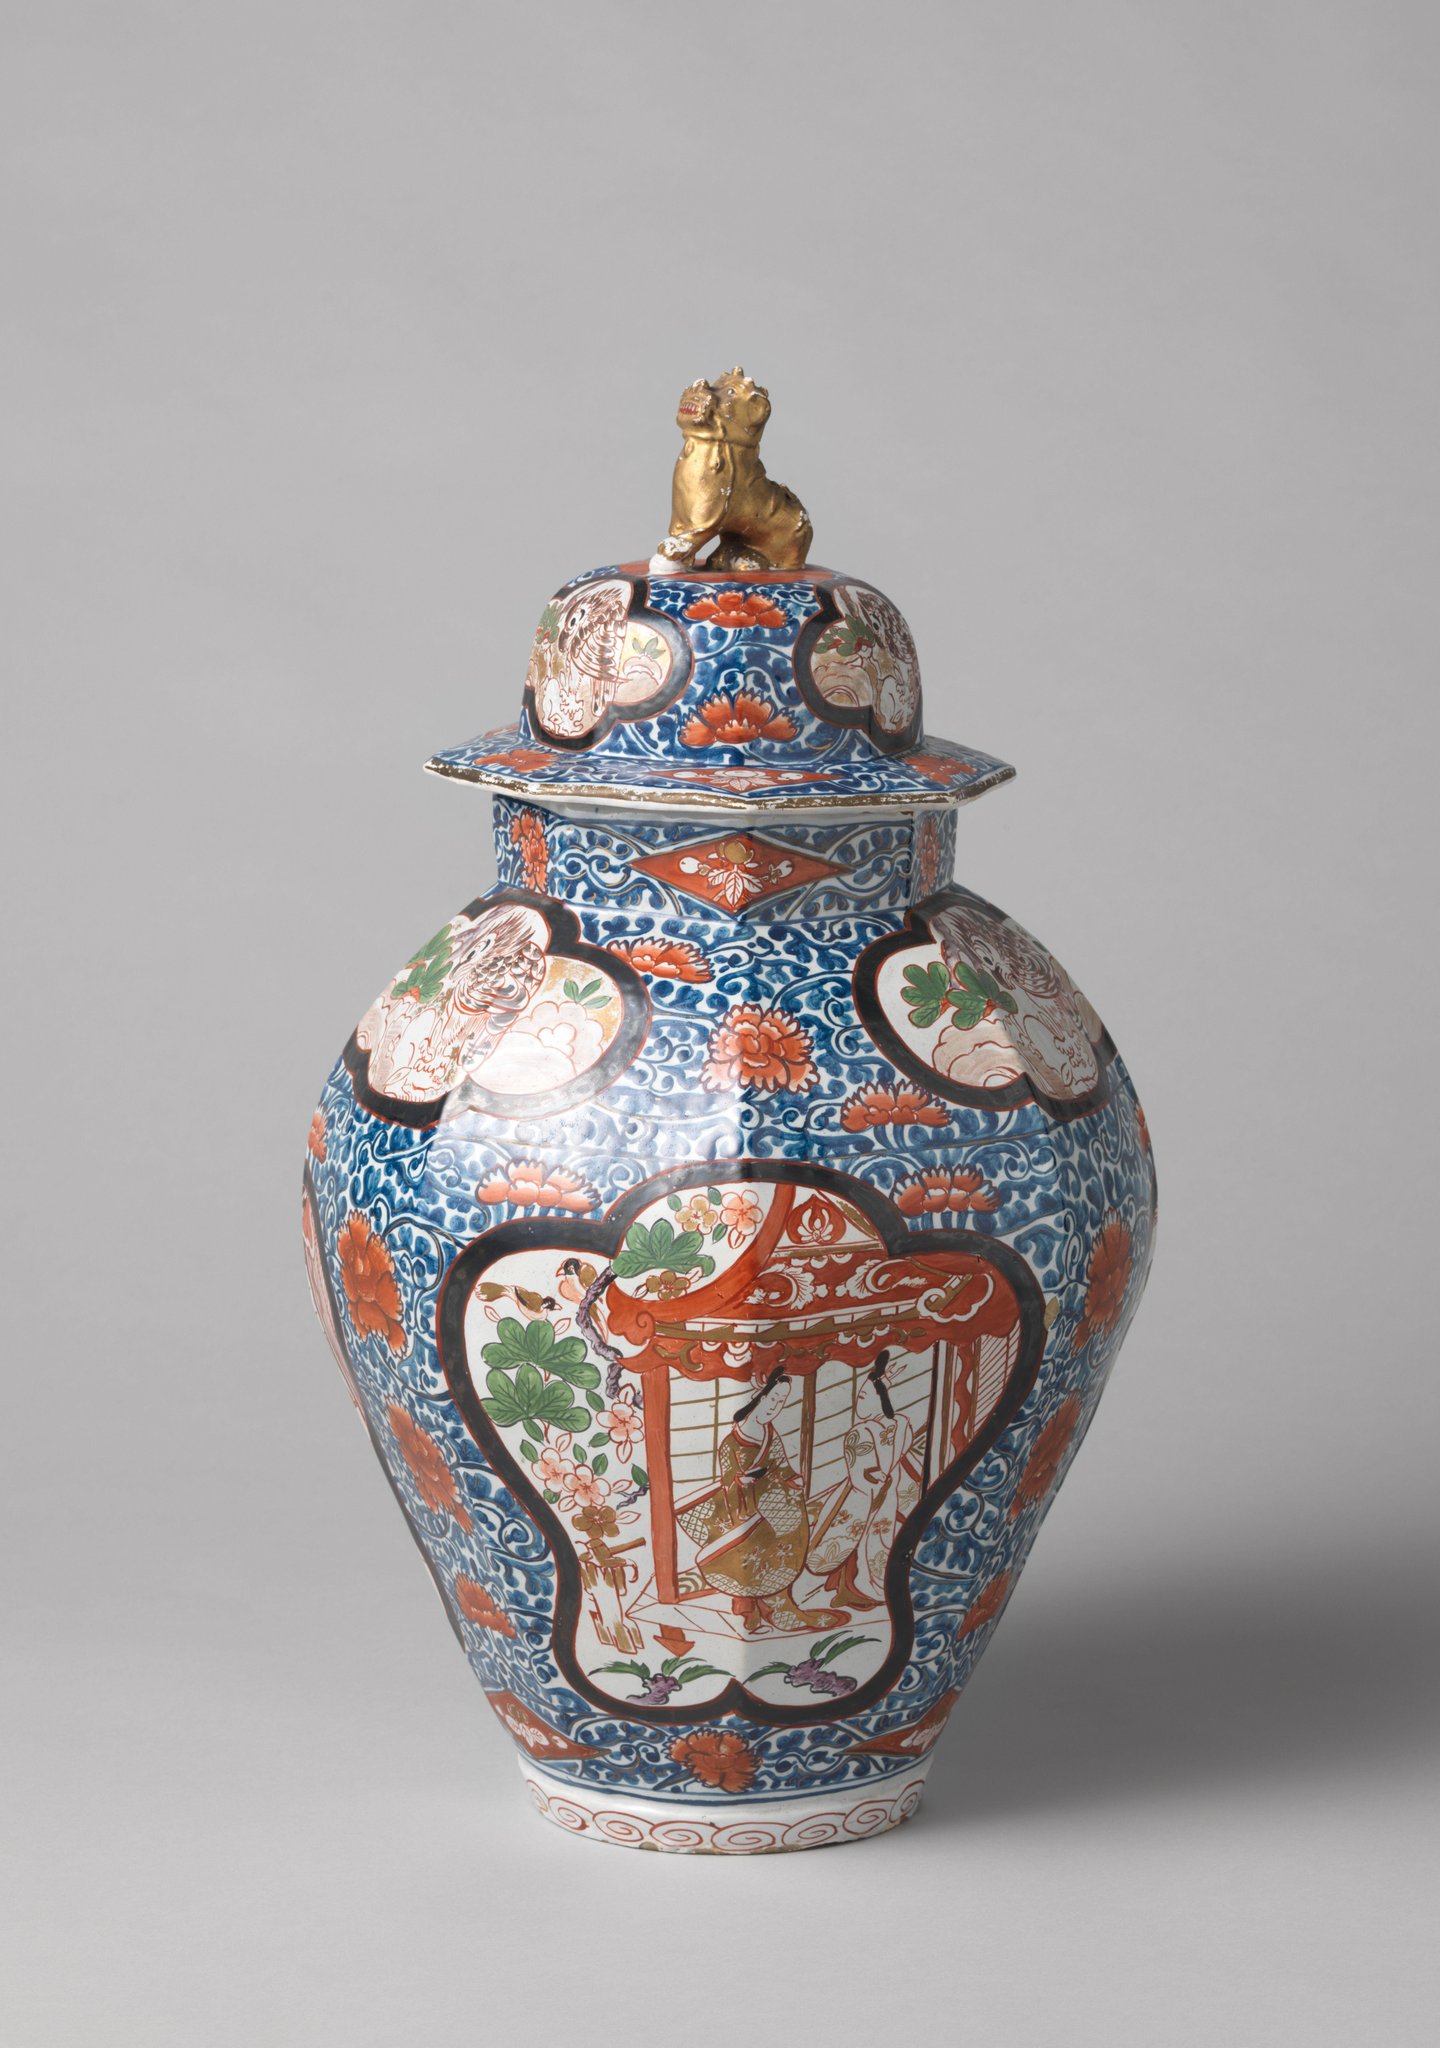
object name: covered jar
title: Deksel van pot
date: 1830-1850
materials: faience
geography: delft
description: Deksel van pot van faience. Veelkleurig beschilderd met Japans Imari decor. De dekselpot is onderdeel van een kaststel.